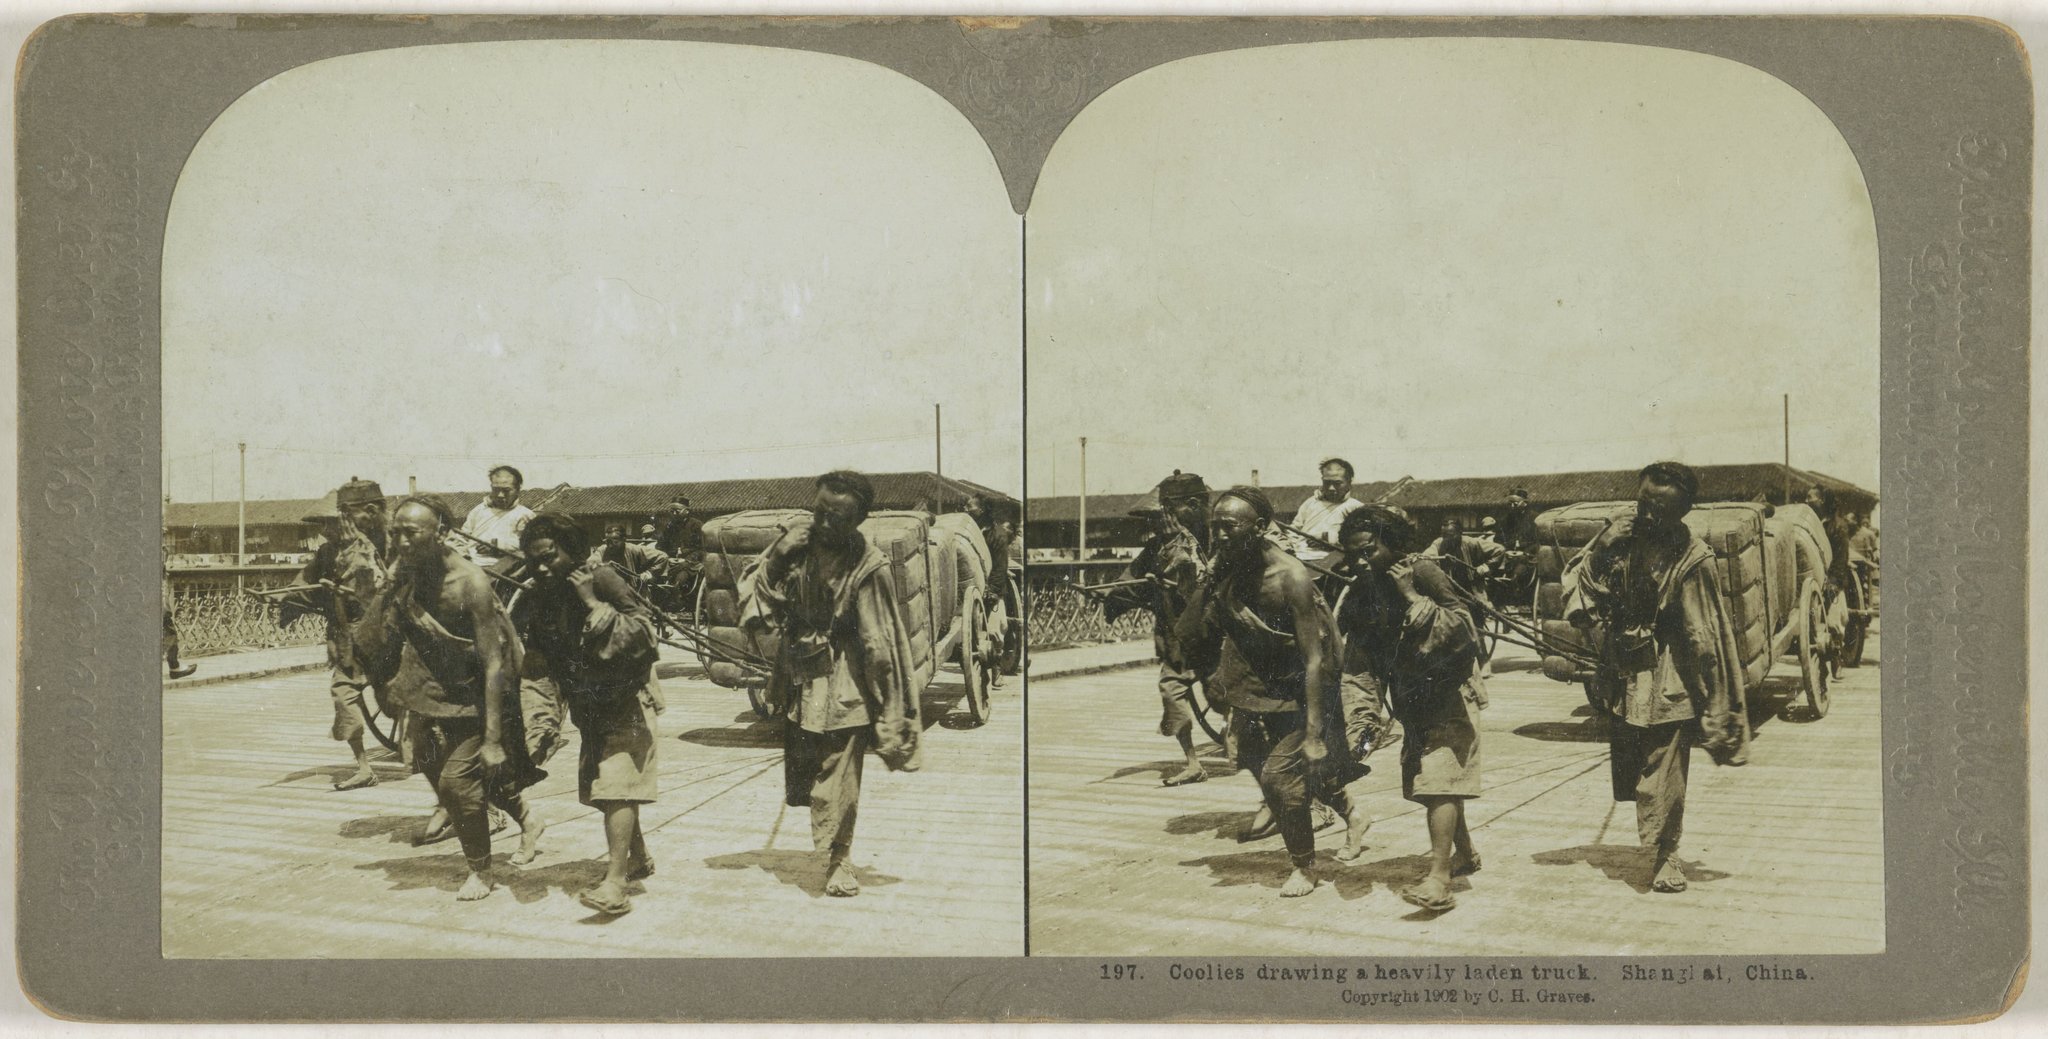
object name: stereograph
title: Coolies drawing a heavily laden truck. Shanghai, China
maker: carleton harlow graves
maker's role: fotograaf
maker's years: 1867-1943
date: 1902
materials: paper, cardboard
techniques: gelatin silver print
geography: shanghai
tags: drawing, pulling something, hand-cart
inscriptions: number: ‘70’, copyright notice: ‘Copyright 1902 by C. H. Graves.’, number: ‘197.’